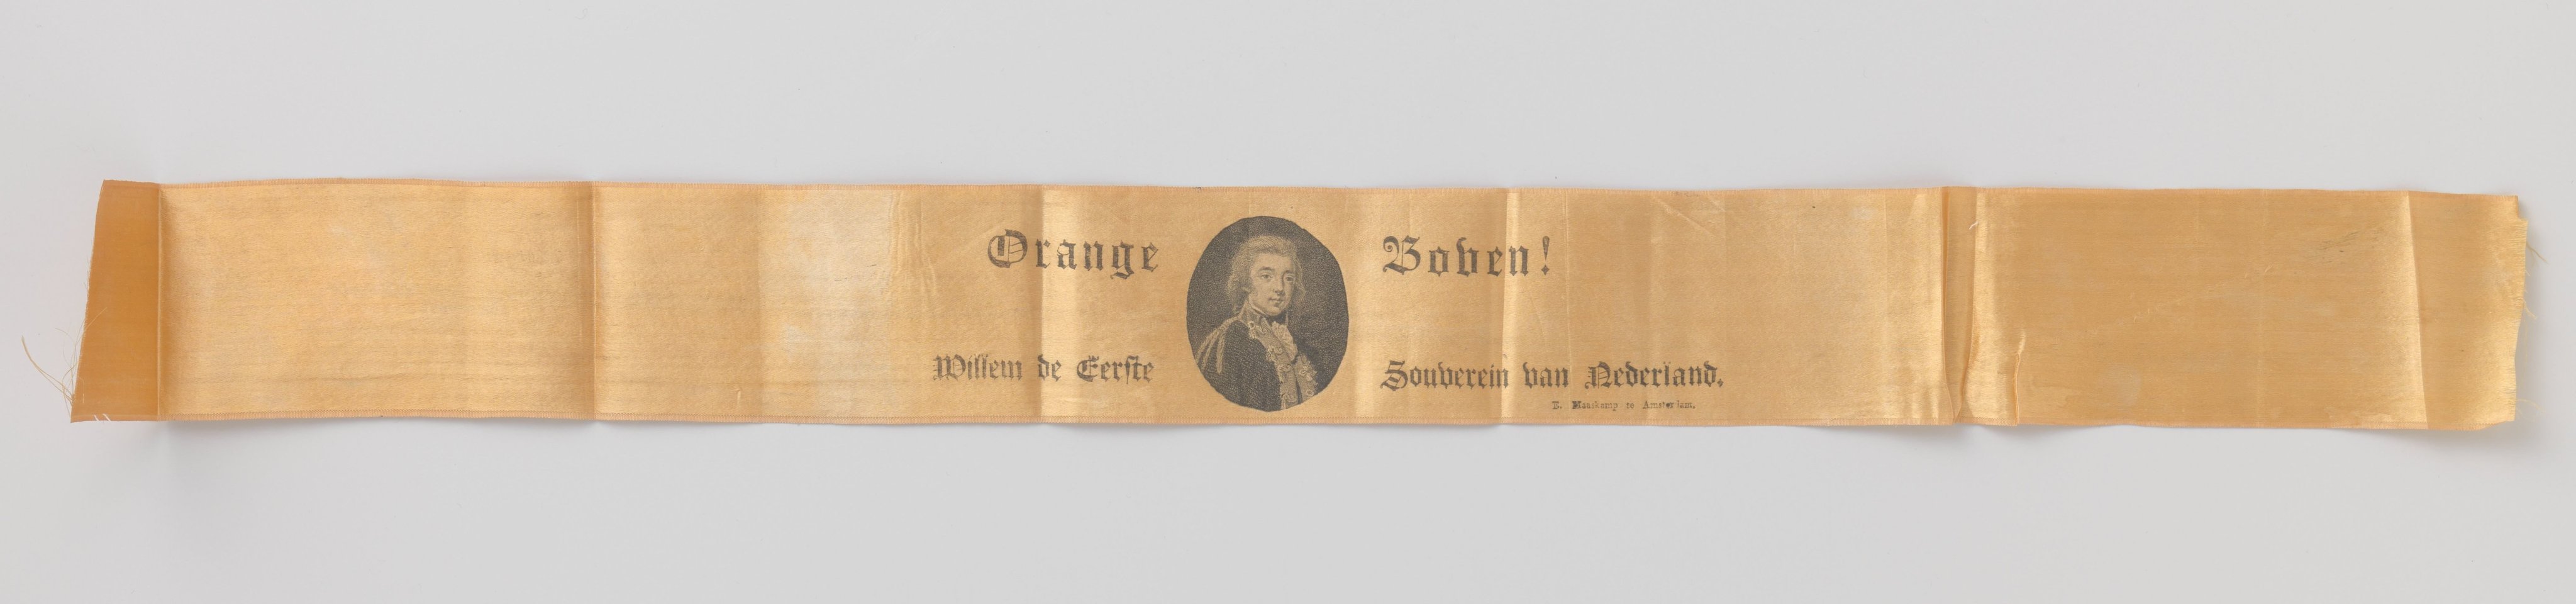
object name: clothing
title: Lint van oranje satijn, waarop in stippelgravure een ovaal portret van erfprins Willem Frederik (later koning Willem I) in uniform van 'Garde de corps', met onderschrift: 'Orange Boven !// Willem de Eerste - Souverein van Nederland // E. Maaskamp te Amsterdam'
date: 1813-1814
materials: ink, silk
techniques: engraving, weave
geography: amsterdam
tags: the hague, berlin, william i of the netherlands, brussels, amsterdam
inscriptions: inscription: ‘Orange - Boven ! // Willem de Eerste - Souverein van Nederland . // E. Maaskamp te Amsterdam.’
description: Lint van oranje satijn, waarop in stippelgravure een ovaal portret van erfprins Willem Frederik (later koning Willem I) in uniform van 'Garde de corps'. Voorstelling: de jongere, erfprins Willem Frederik (1772-1843). Borststuk naar rechts, met iets golvend halflang haar, van voren omhoog en uit het gezicht gekamd. Uniformrok met staande kraag, zwarte halsdoek, lichtere omslagen met brandebourgs, jabots die uit de gesloten jas tevoorschijn komen en een een schouderbedekking die in drie koorden uitloopt (uniform van de Garde de corps). Het ovaal is in de breedte van het lint gedrukt.